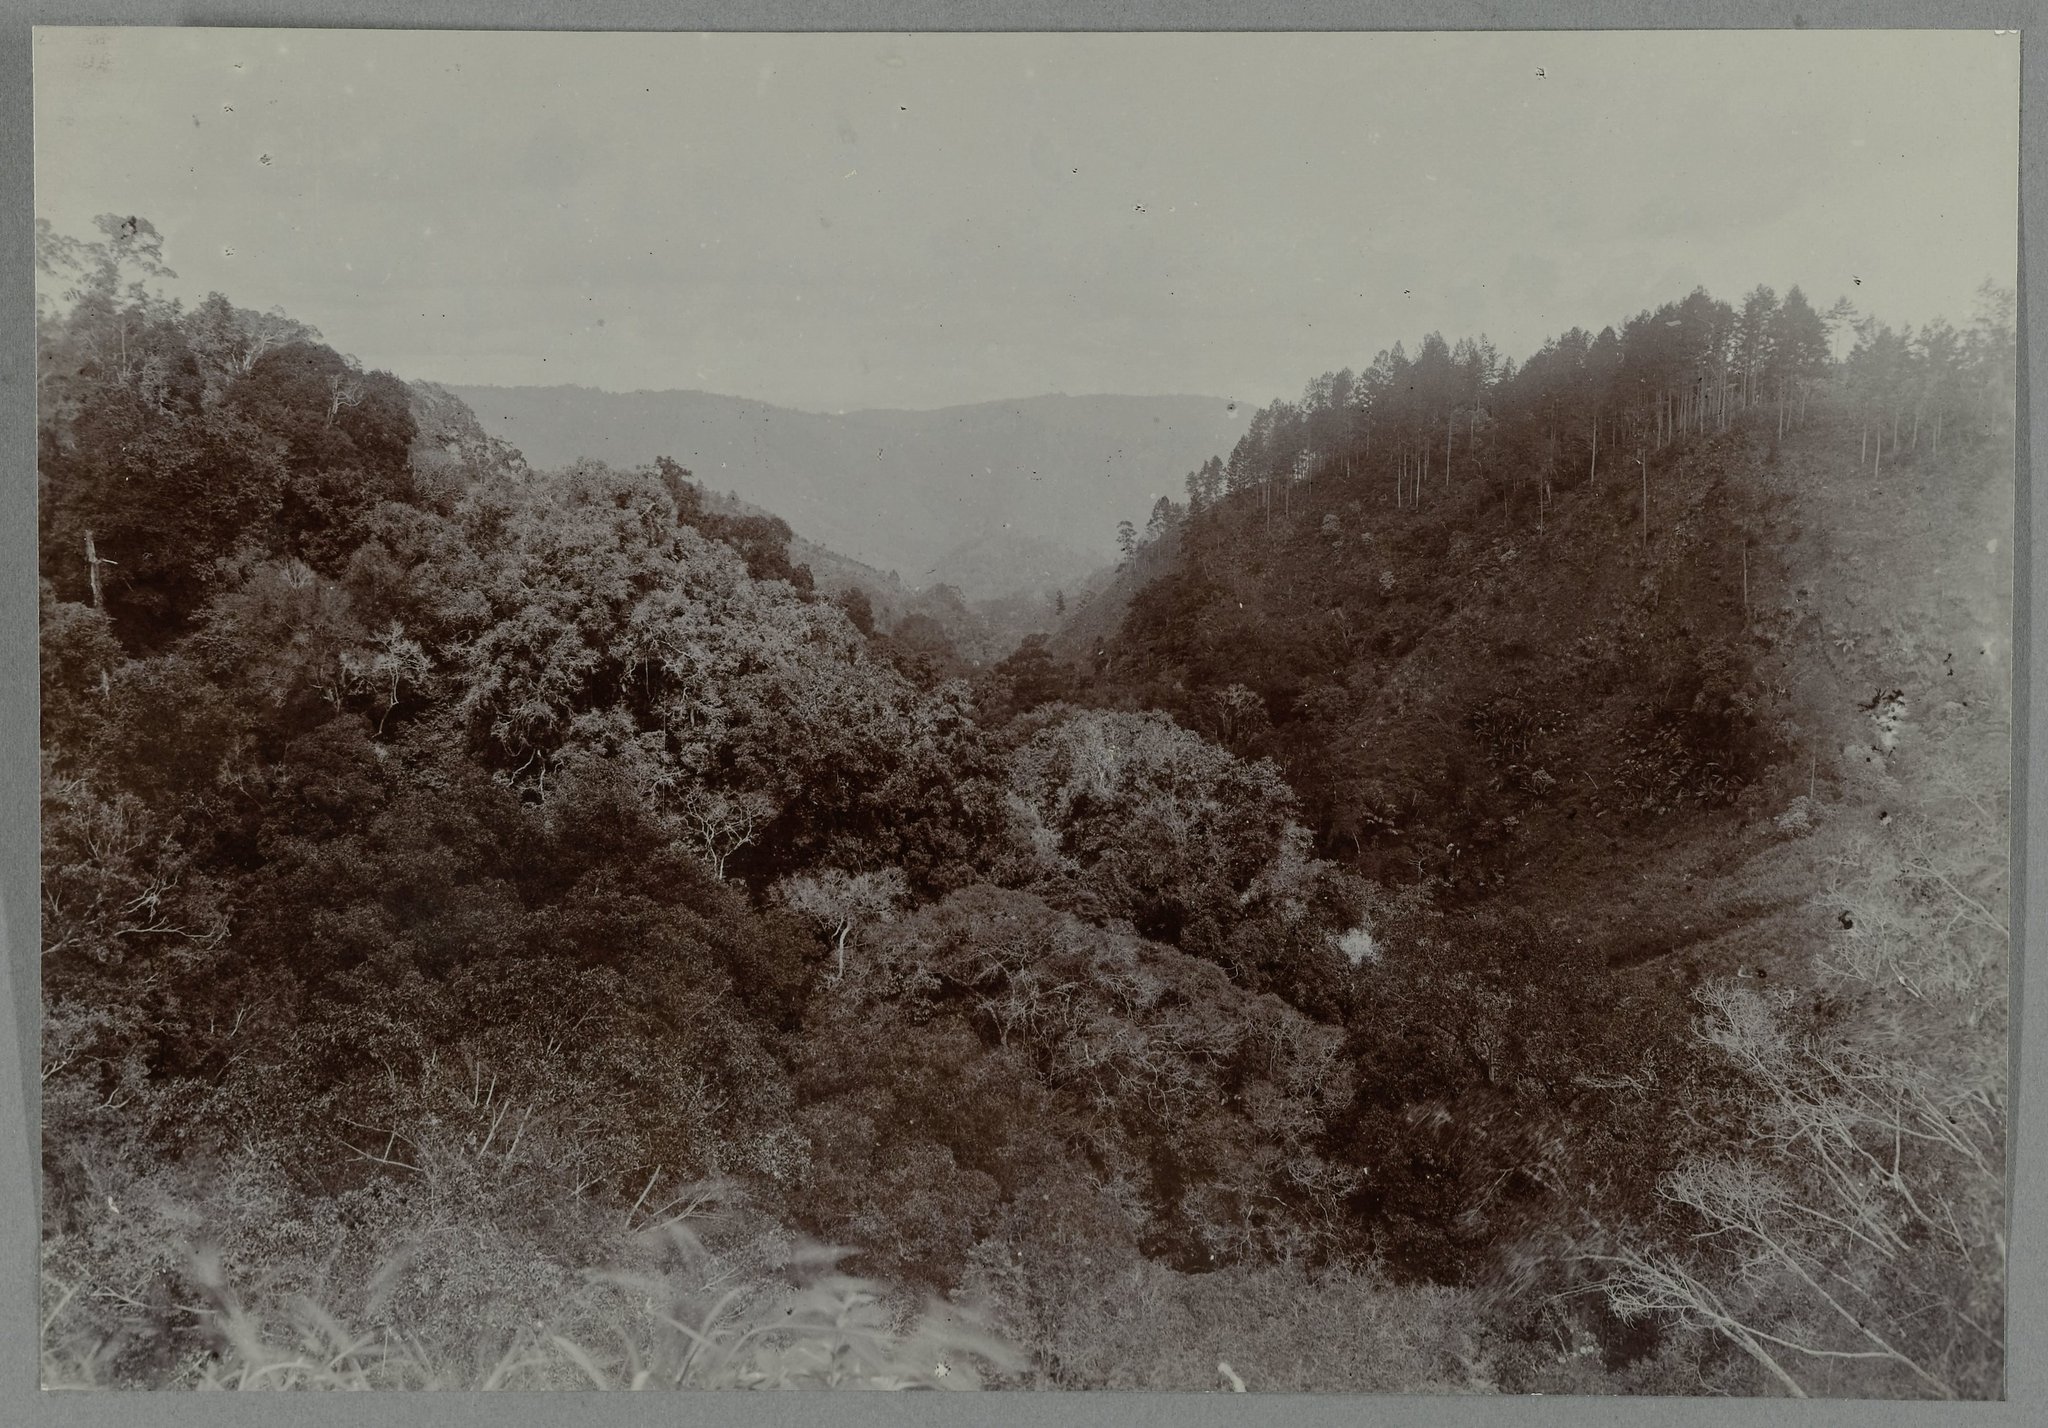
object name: photograph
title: Boslandschap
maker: Anonymous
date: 1903-1913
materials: photographic support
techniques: photography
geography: north sumatra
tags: arnhem, the hague, albertus dominicus laman trip, truck, van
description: Na de expedities naar de Gajo- en Alaslanden o.l.v. Van Daalen (eerste tocht in 1901), werd hij in 1903 belast met voorbereiding van permanente vestiging van Nederlands gezag. Aanleg van een weg van de Noordkust naar het binnenland was hierbij van groot belang. Deze zgn. Gajoweg werd aangelegd tussen 1903 en 1914, van Bireuen aan de kust naar Takinguen aan het bergmeer Danau Lauttawar, totale lente 104 km.